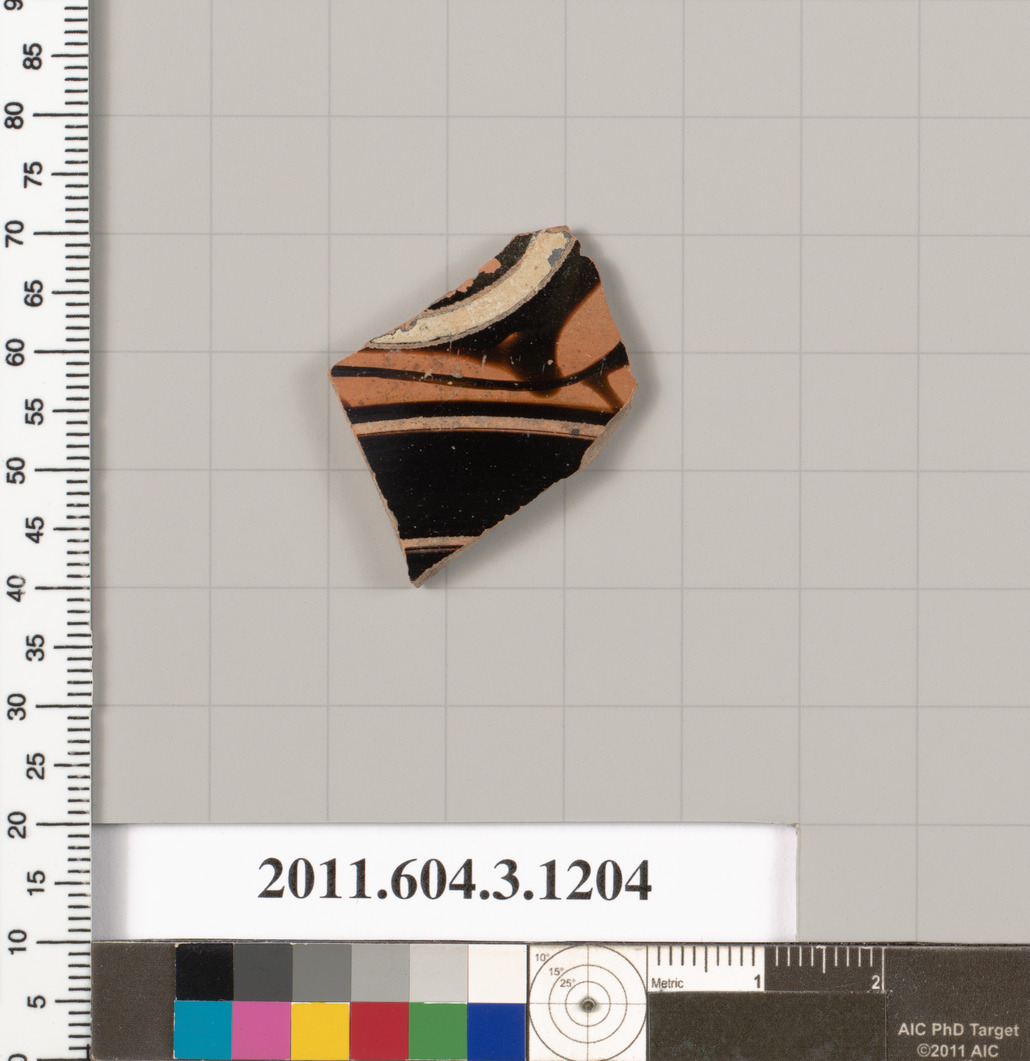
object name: mastoid fragment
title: Terracotta fragment of a mastoid (drinking cup with narrow base)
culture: greek, attic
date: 534-468 BCE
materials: terracotta